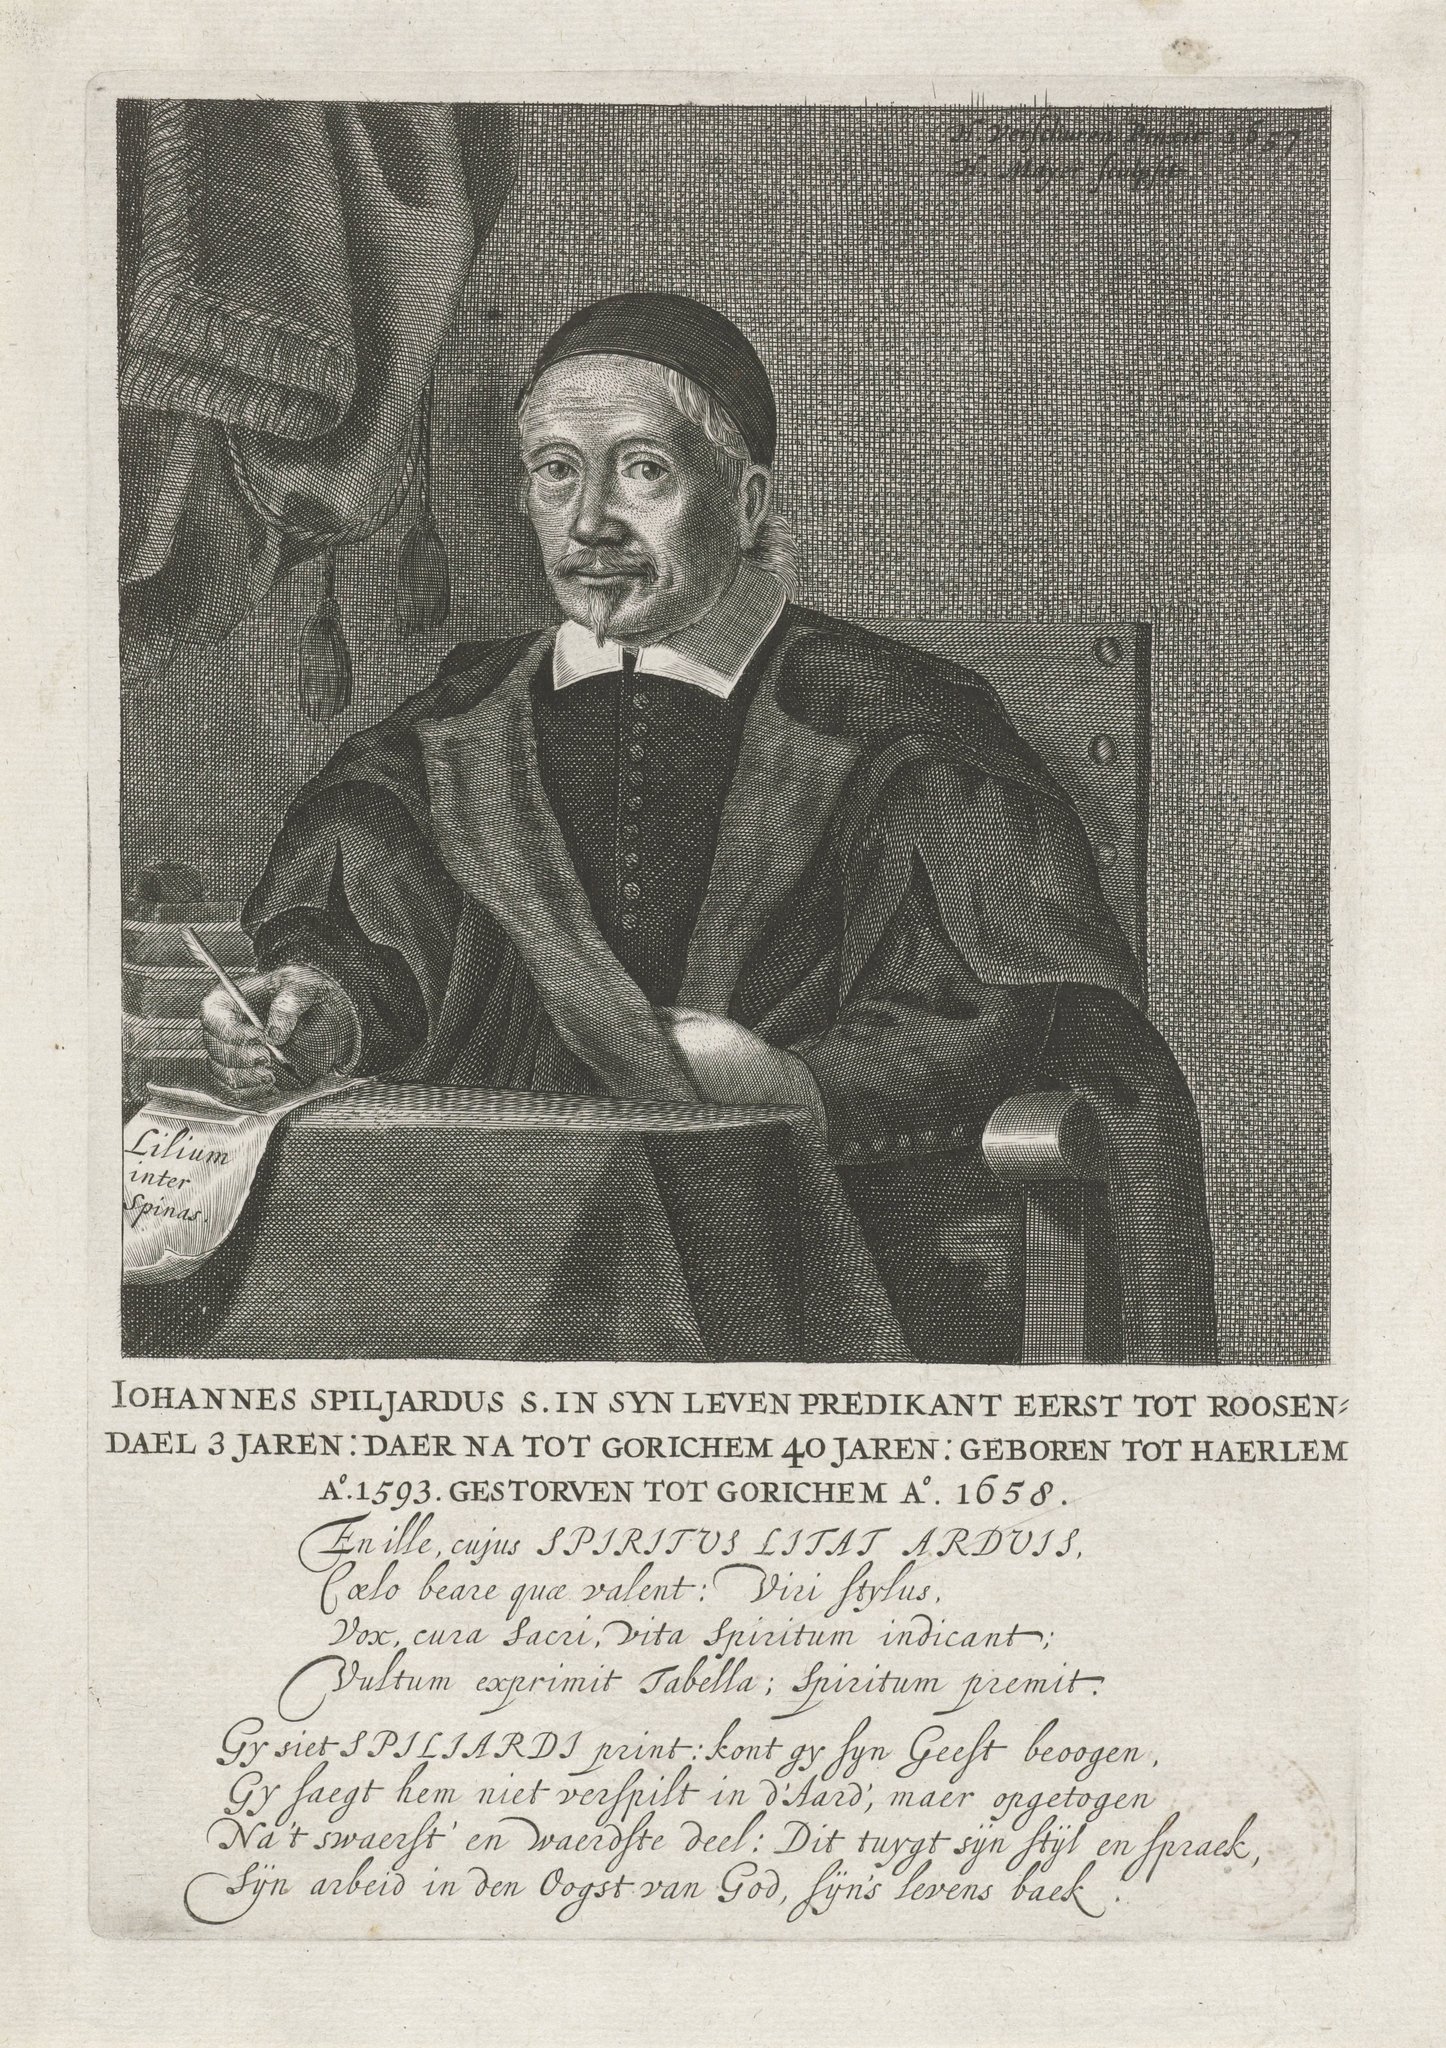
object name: print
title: Portret van Johannes Spiljardus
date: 1658-1660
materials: paper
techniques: engraving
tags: haarlem, pen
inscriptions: collector's mark: Lugt 240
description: Portret van predikant Johannes Spiljardus gezeten aan een tafel met een pen in de hand. Onderaan in de marge een vierregelig vers in het Latijn en het Nederlands.